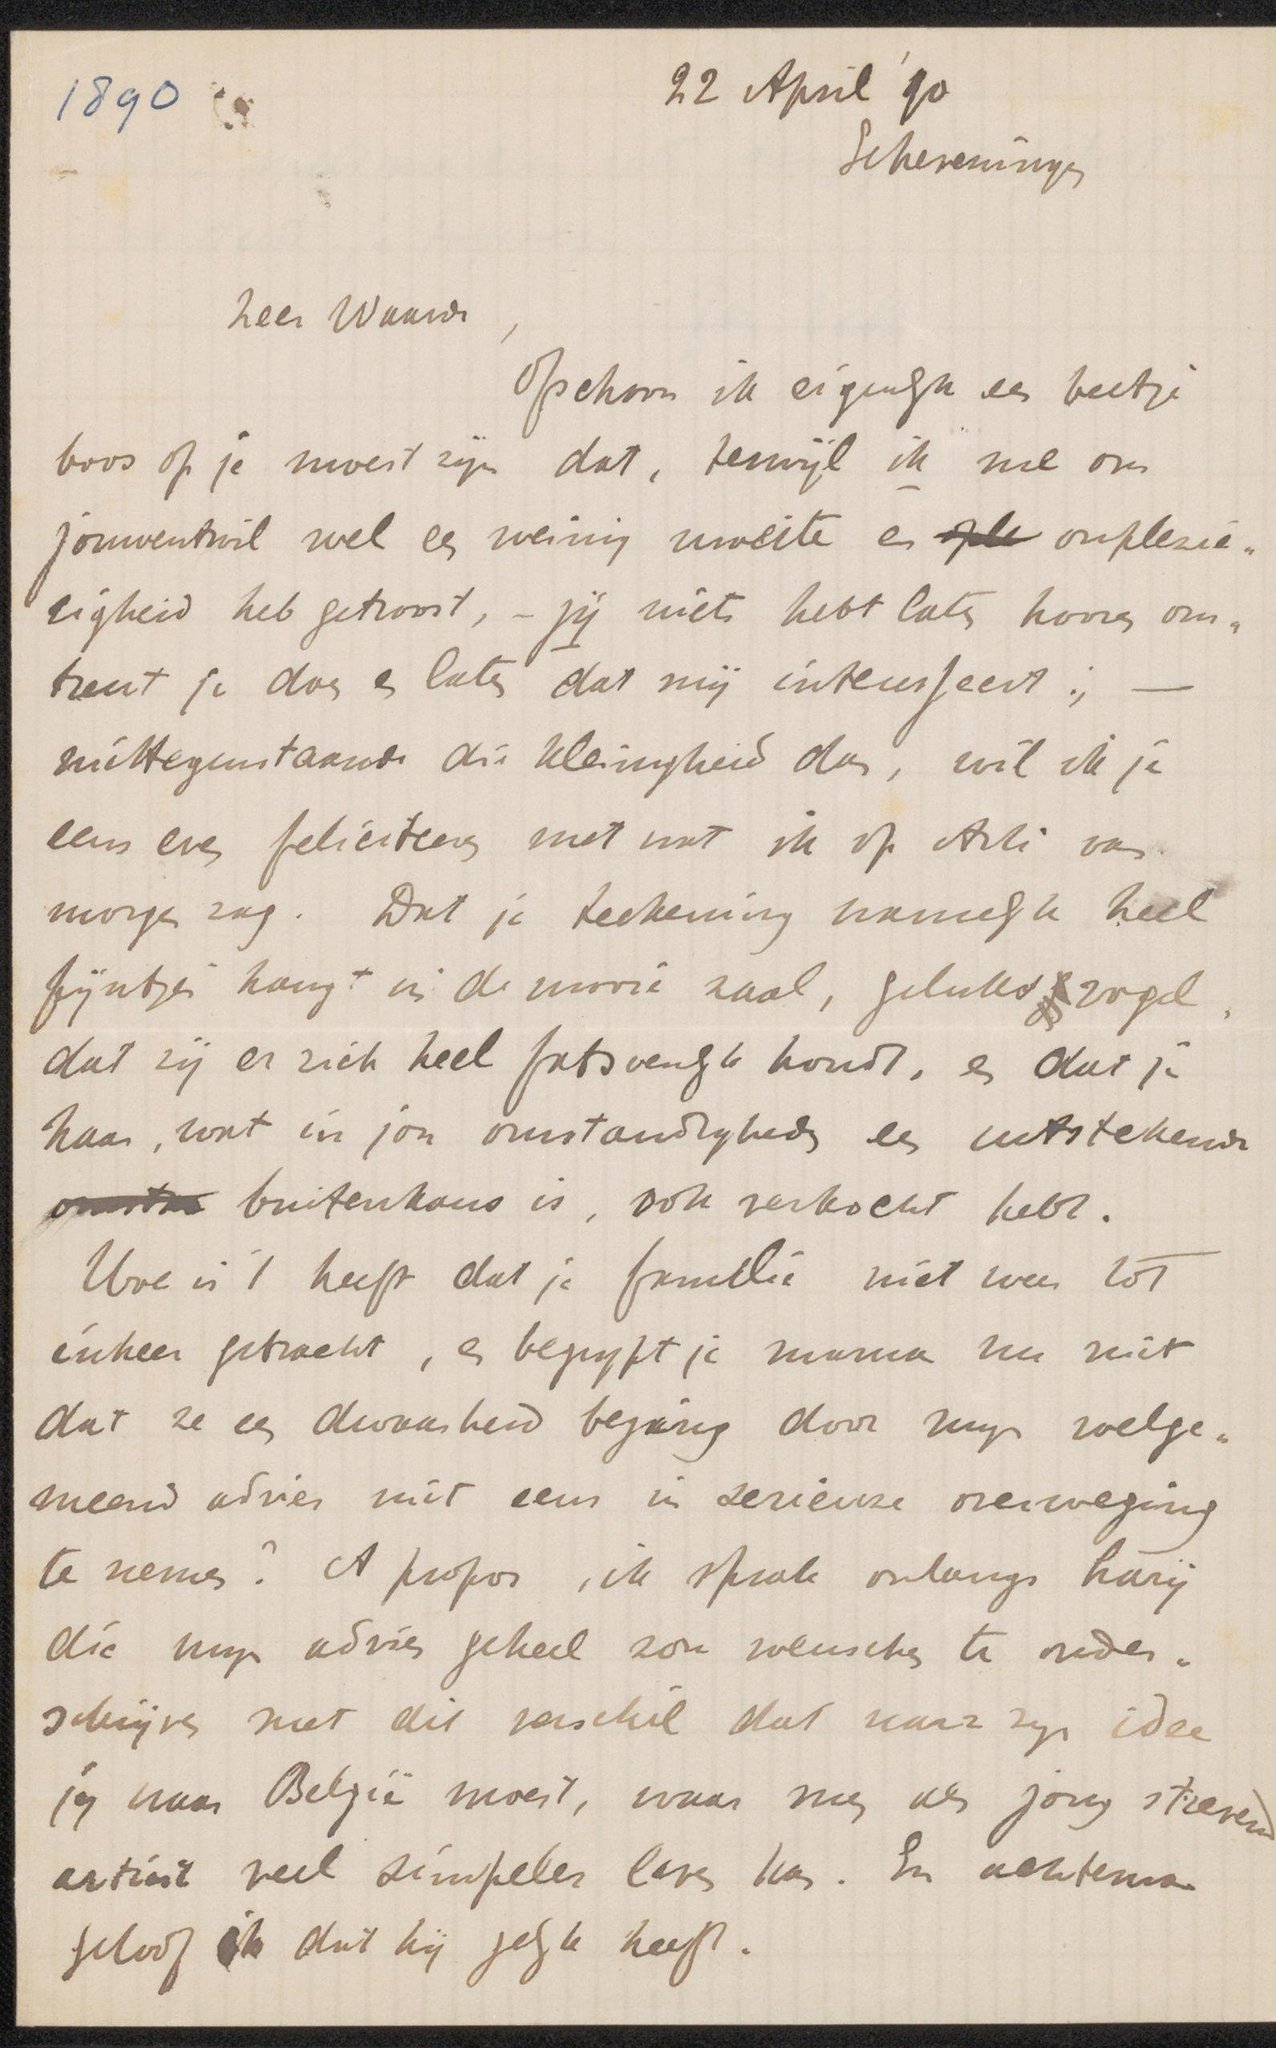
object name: letter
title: Brief aan Cornelis Gerardus 't Hooft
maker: jan veth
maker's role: designer, draughtsman, painter, print maker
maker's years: 1864-1925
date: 1890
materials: ink, paper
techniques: pen, writing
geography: scheveningen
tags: cornelis gerardus 't hooft, drawing, belgium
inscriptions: collector's mark: ‘RPK’